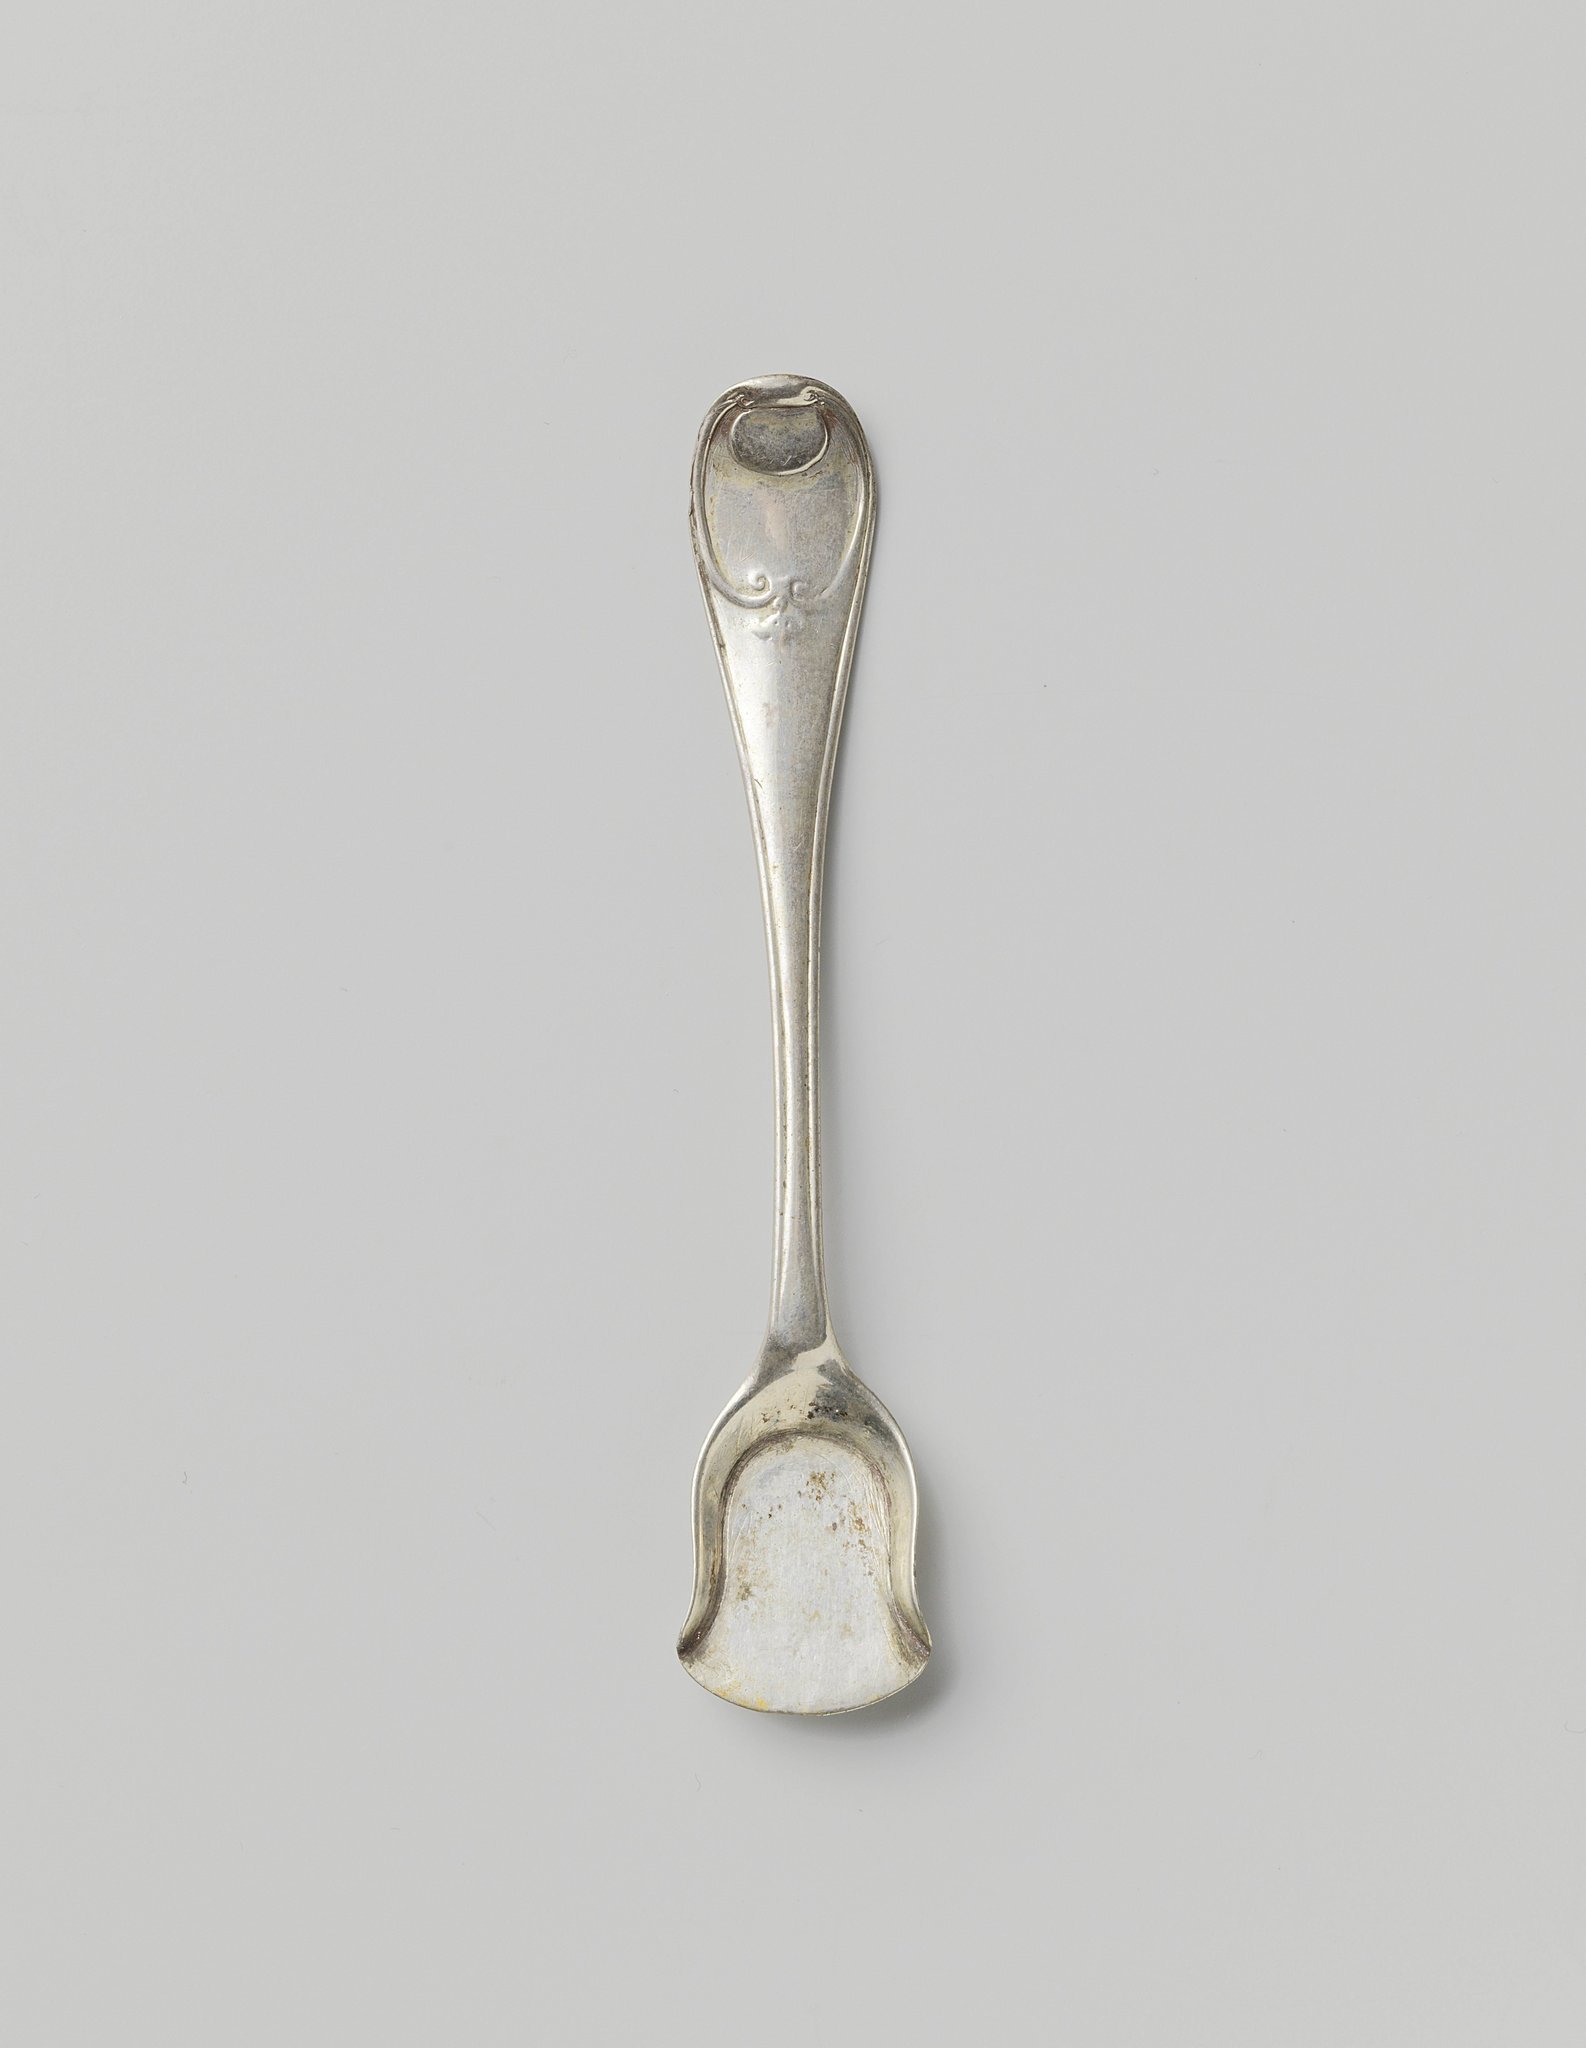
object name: spoon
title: Zoutlepel van zilver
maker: jacob schenk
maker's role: silversmith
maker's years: 1722-1786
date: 1790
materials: silver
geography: amsterdam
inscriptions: mark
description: Zoutlepel van zilver, met schepvormige bak. De onderzijde van het uiteinde van de steel is gegraveerd.